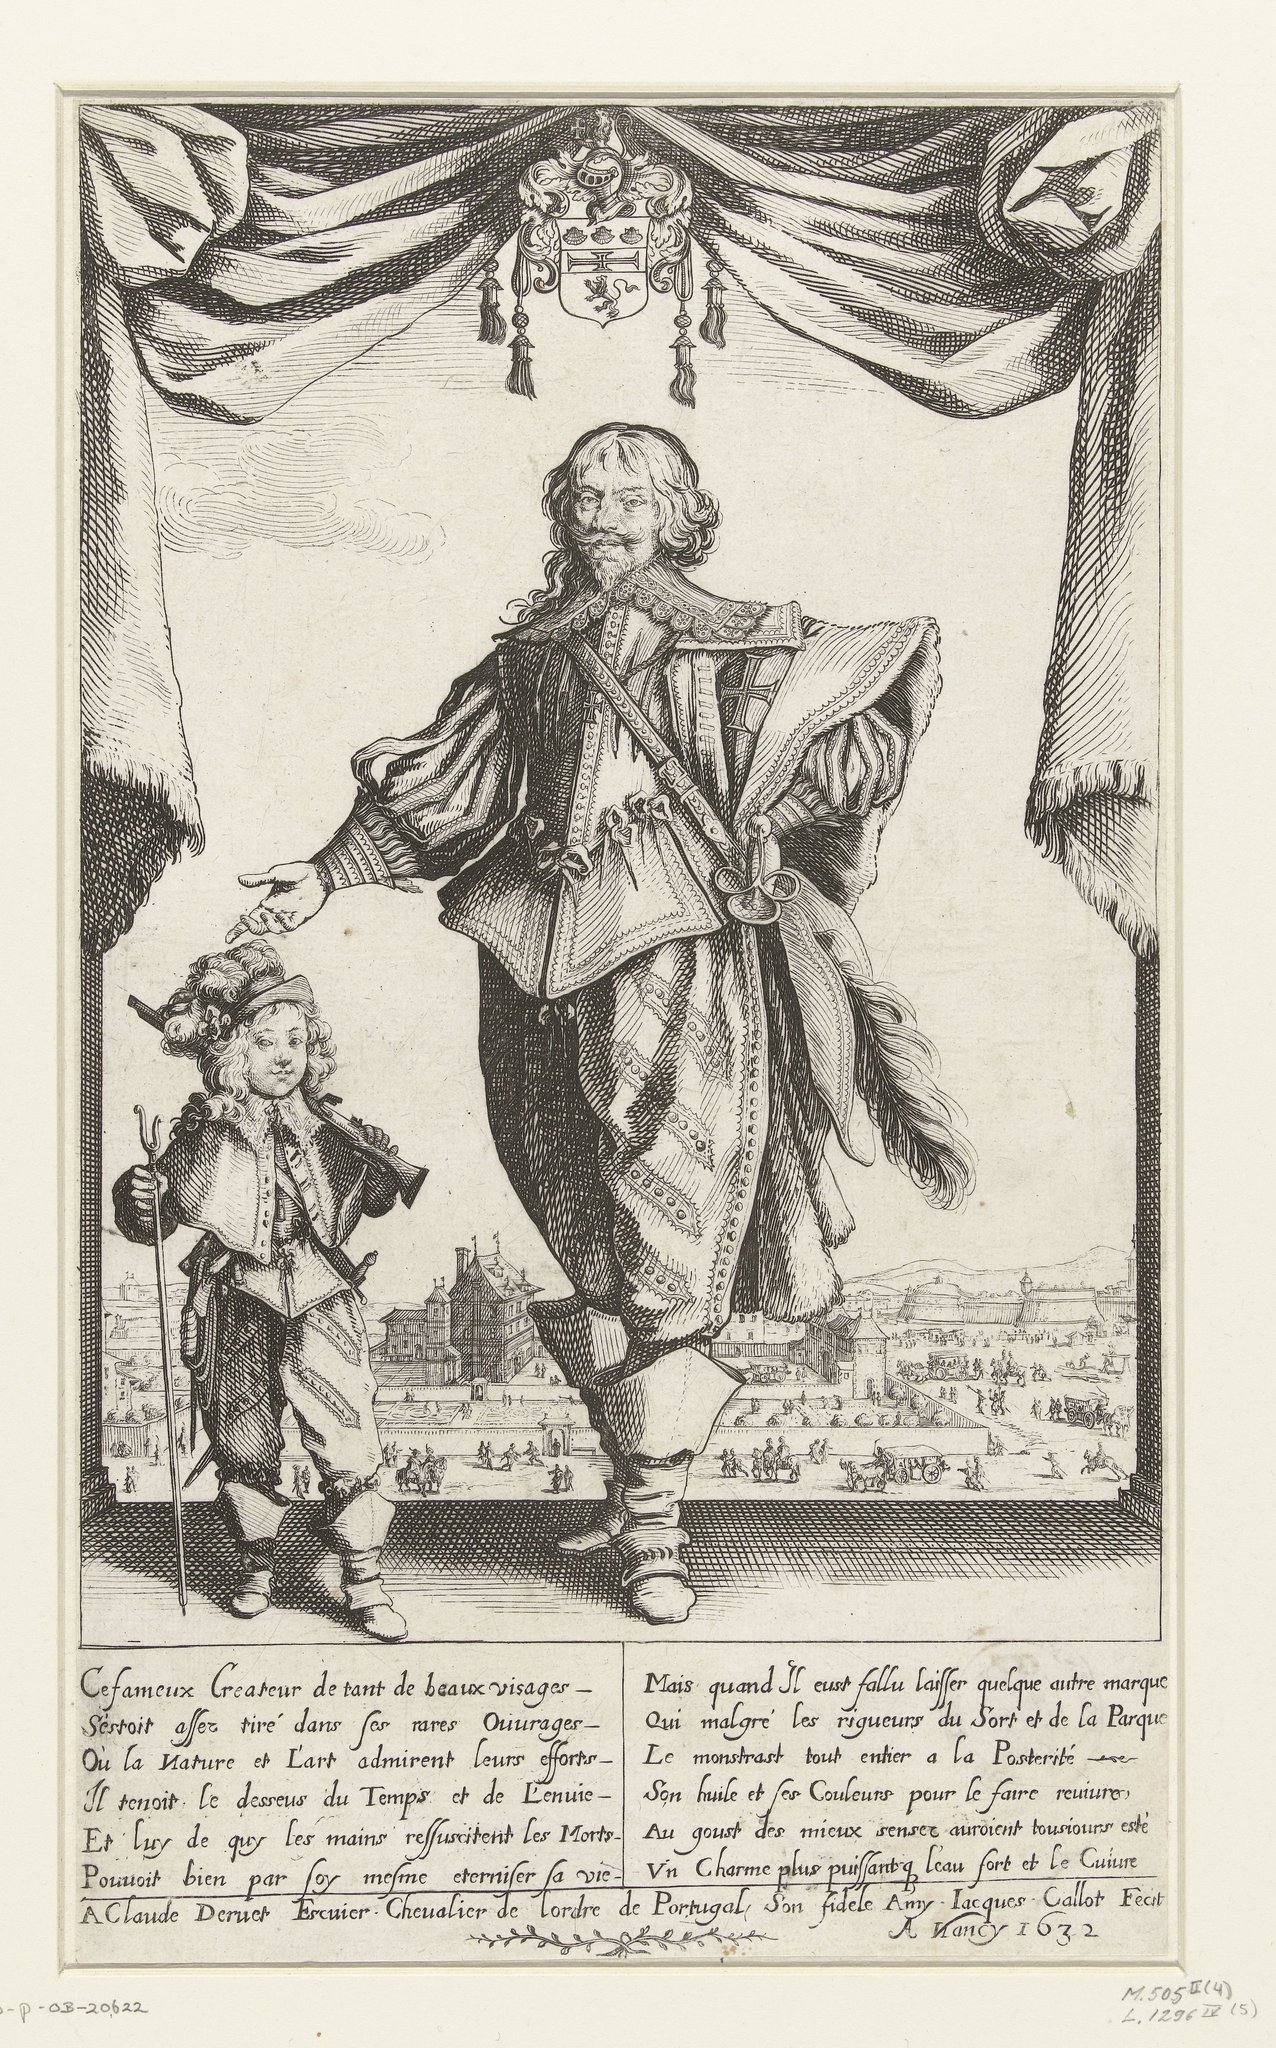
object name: print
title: Portret van de schilder Claude Deruet en zijn zoon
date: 1632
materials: paper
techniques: engraving, etching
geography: nancy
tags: claude deruet, portrait, self-portrait of painter, city-walls, firearms: rifle, father with son(s) (father-love), armorial bearing, heraldry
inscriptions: collector's mark: Lugt 240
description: Portret ten voeten uit van Claude Deruet en zijn zoontje, staand op een soort toneel omlijst met gordijnen. Eerstgenoemde draagt een zwaard op zijn heup, laatstgenoemde een klein musket en furket (steunvork voor de loop van het geweer). Boven hun hoofden een wapenschild. Op de achtergrond de stadsmuren van Nancy. Onder de voorstelling een berijmde Franse tekst.